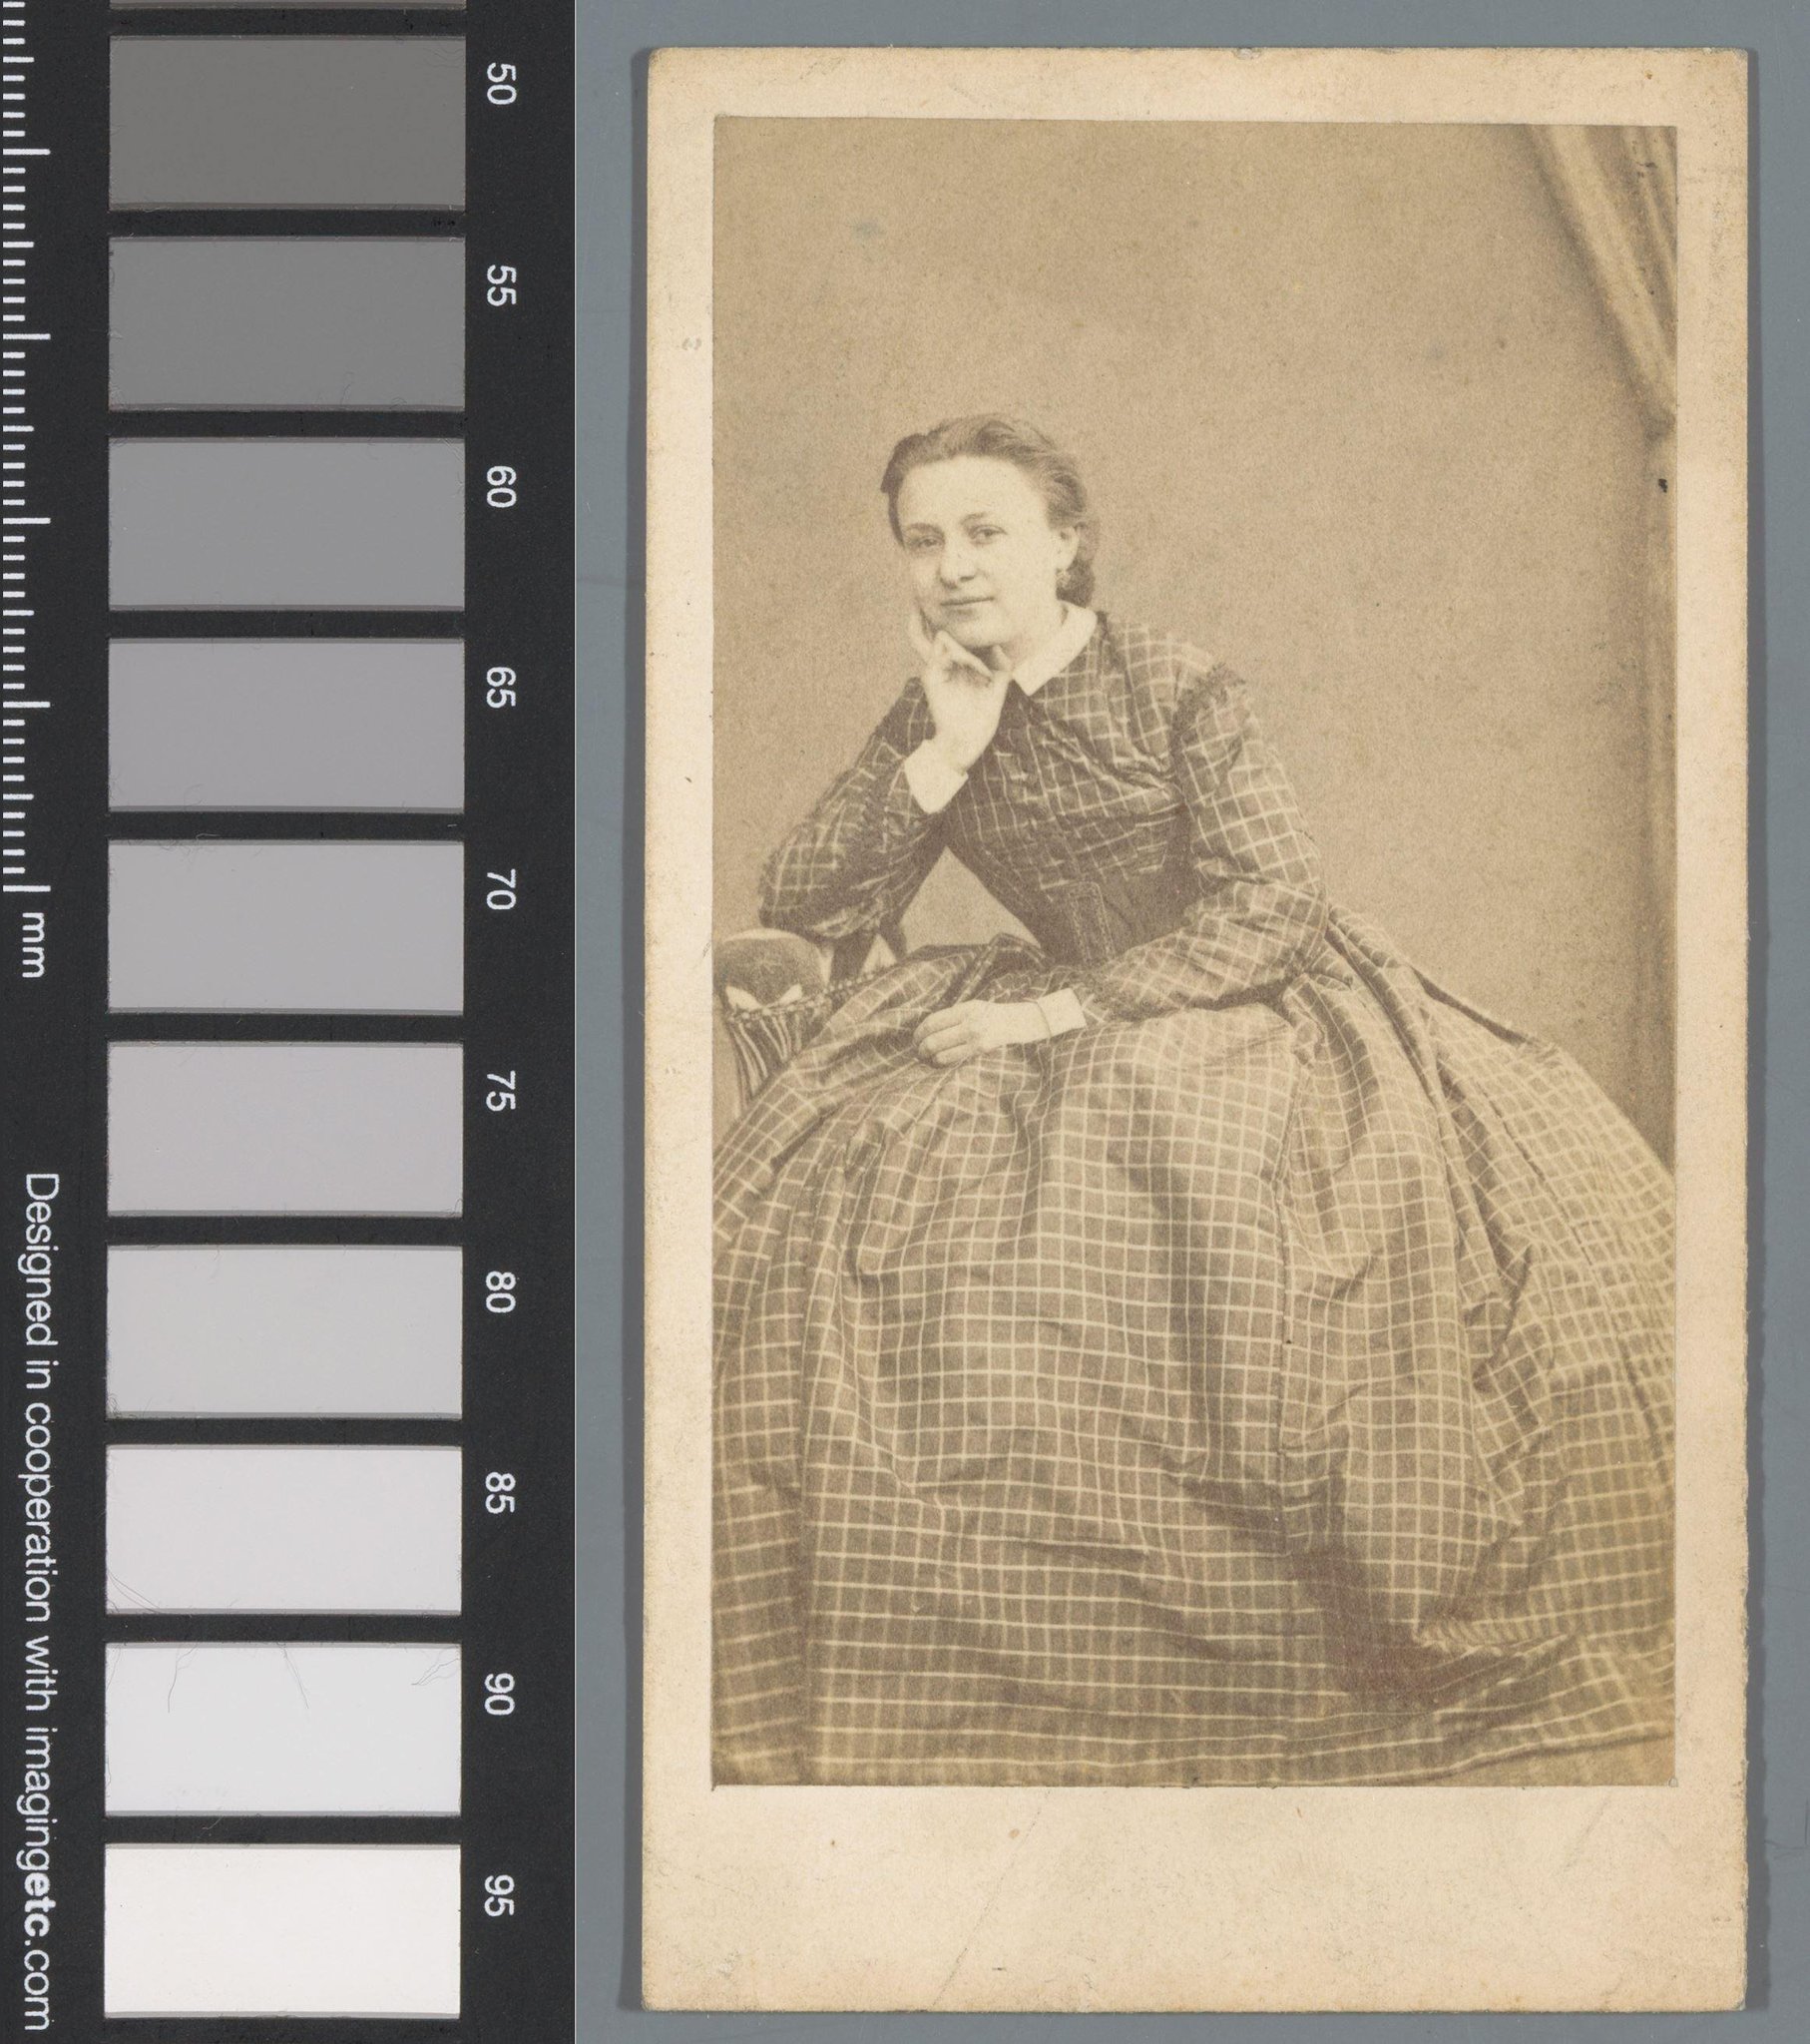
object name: carte de visite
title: Portret van een onbekende vrouw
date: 1855-1885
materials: cardboard, paper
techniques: albumen print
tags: sitting figure, historical persons - bb - woman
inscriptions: inscription: ‘C. DELIGNE &/ A DELERIVE/ AMATEURS/ PHOTOGRAPHES’